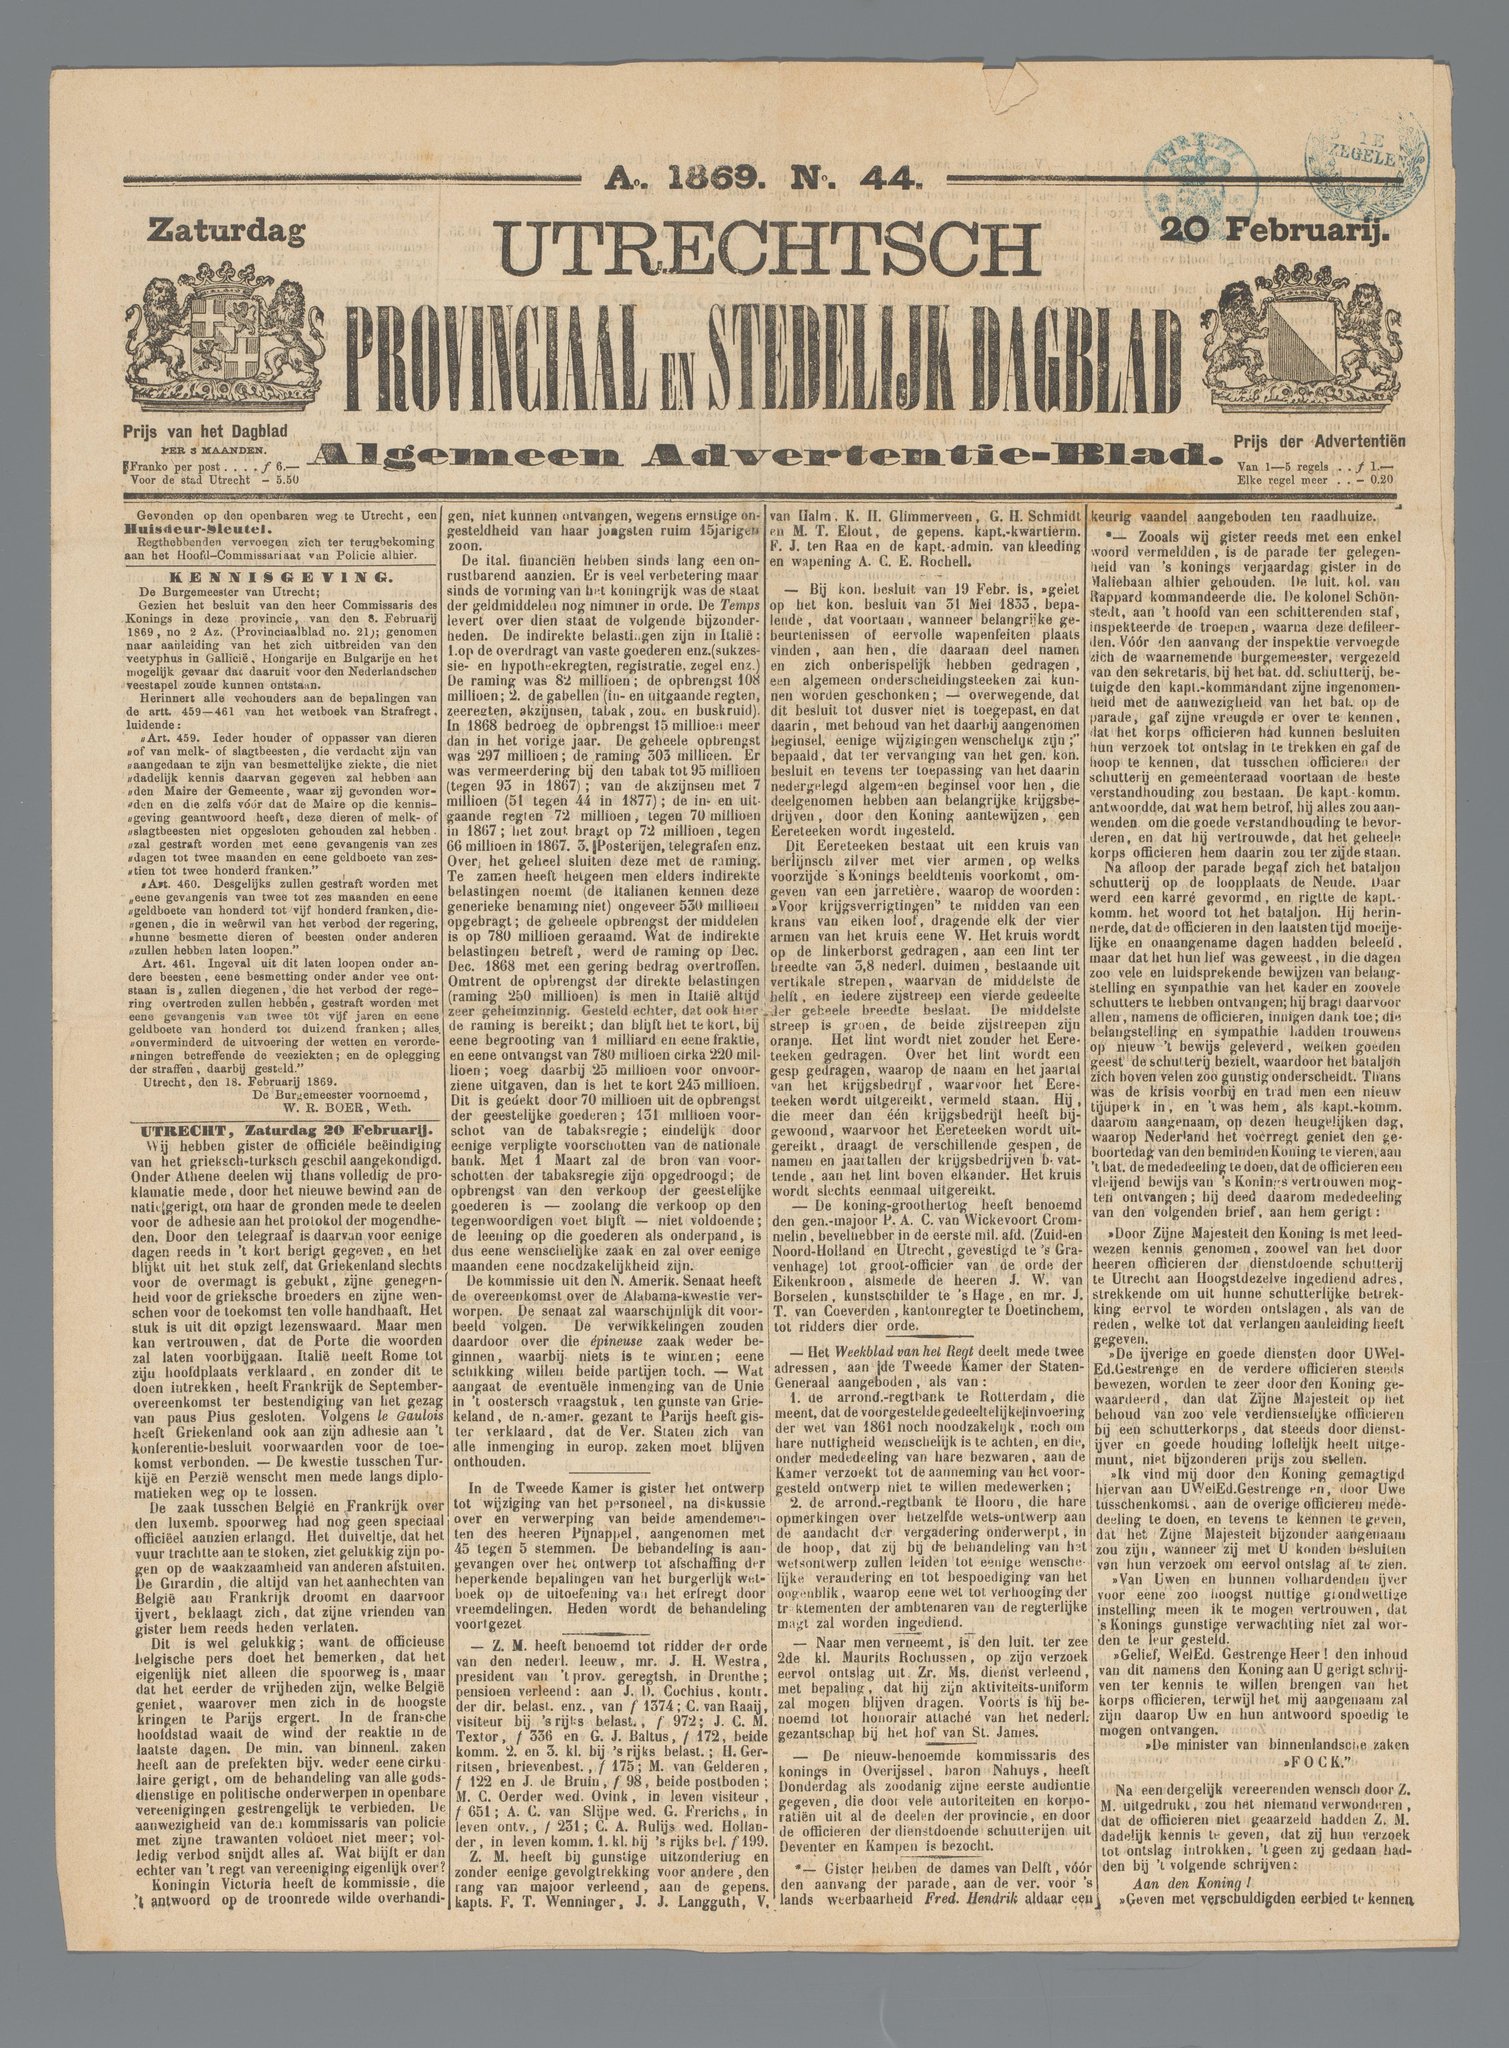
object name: newspaper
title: Utrechts provinciaal en stedelijk dagblad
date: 1869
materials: paper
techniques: printing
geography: utrecht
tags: netherlands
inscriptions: date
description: 4 pp, Ao. 1869, nr. 44. Gemerkt; r.b.: stempel: 'Te / Zegelen'. Gedateerd.